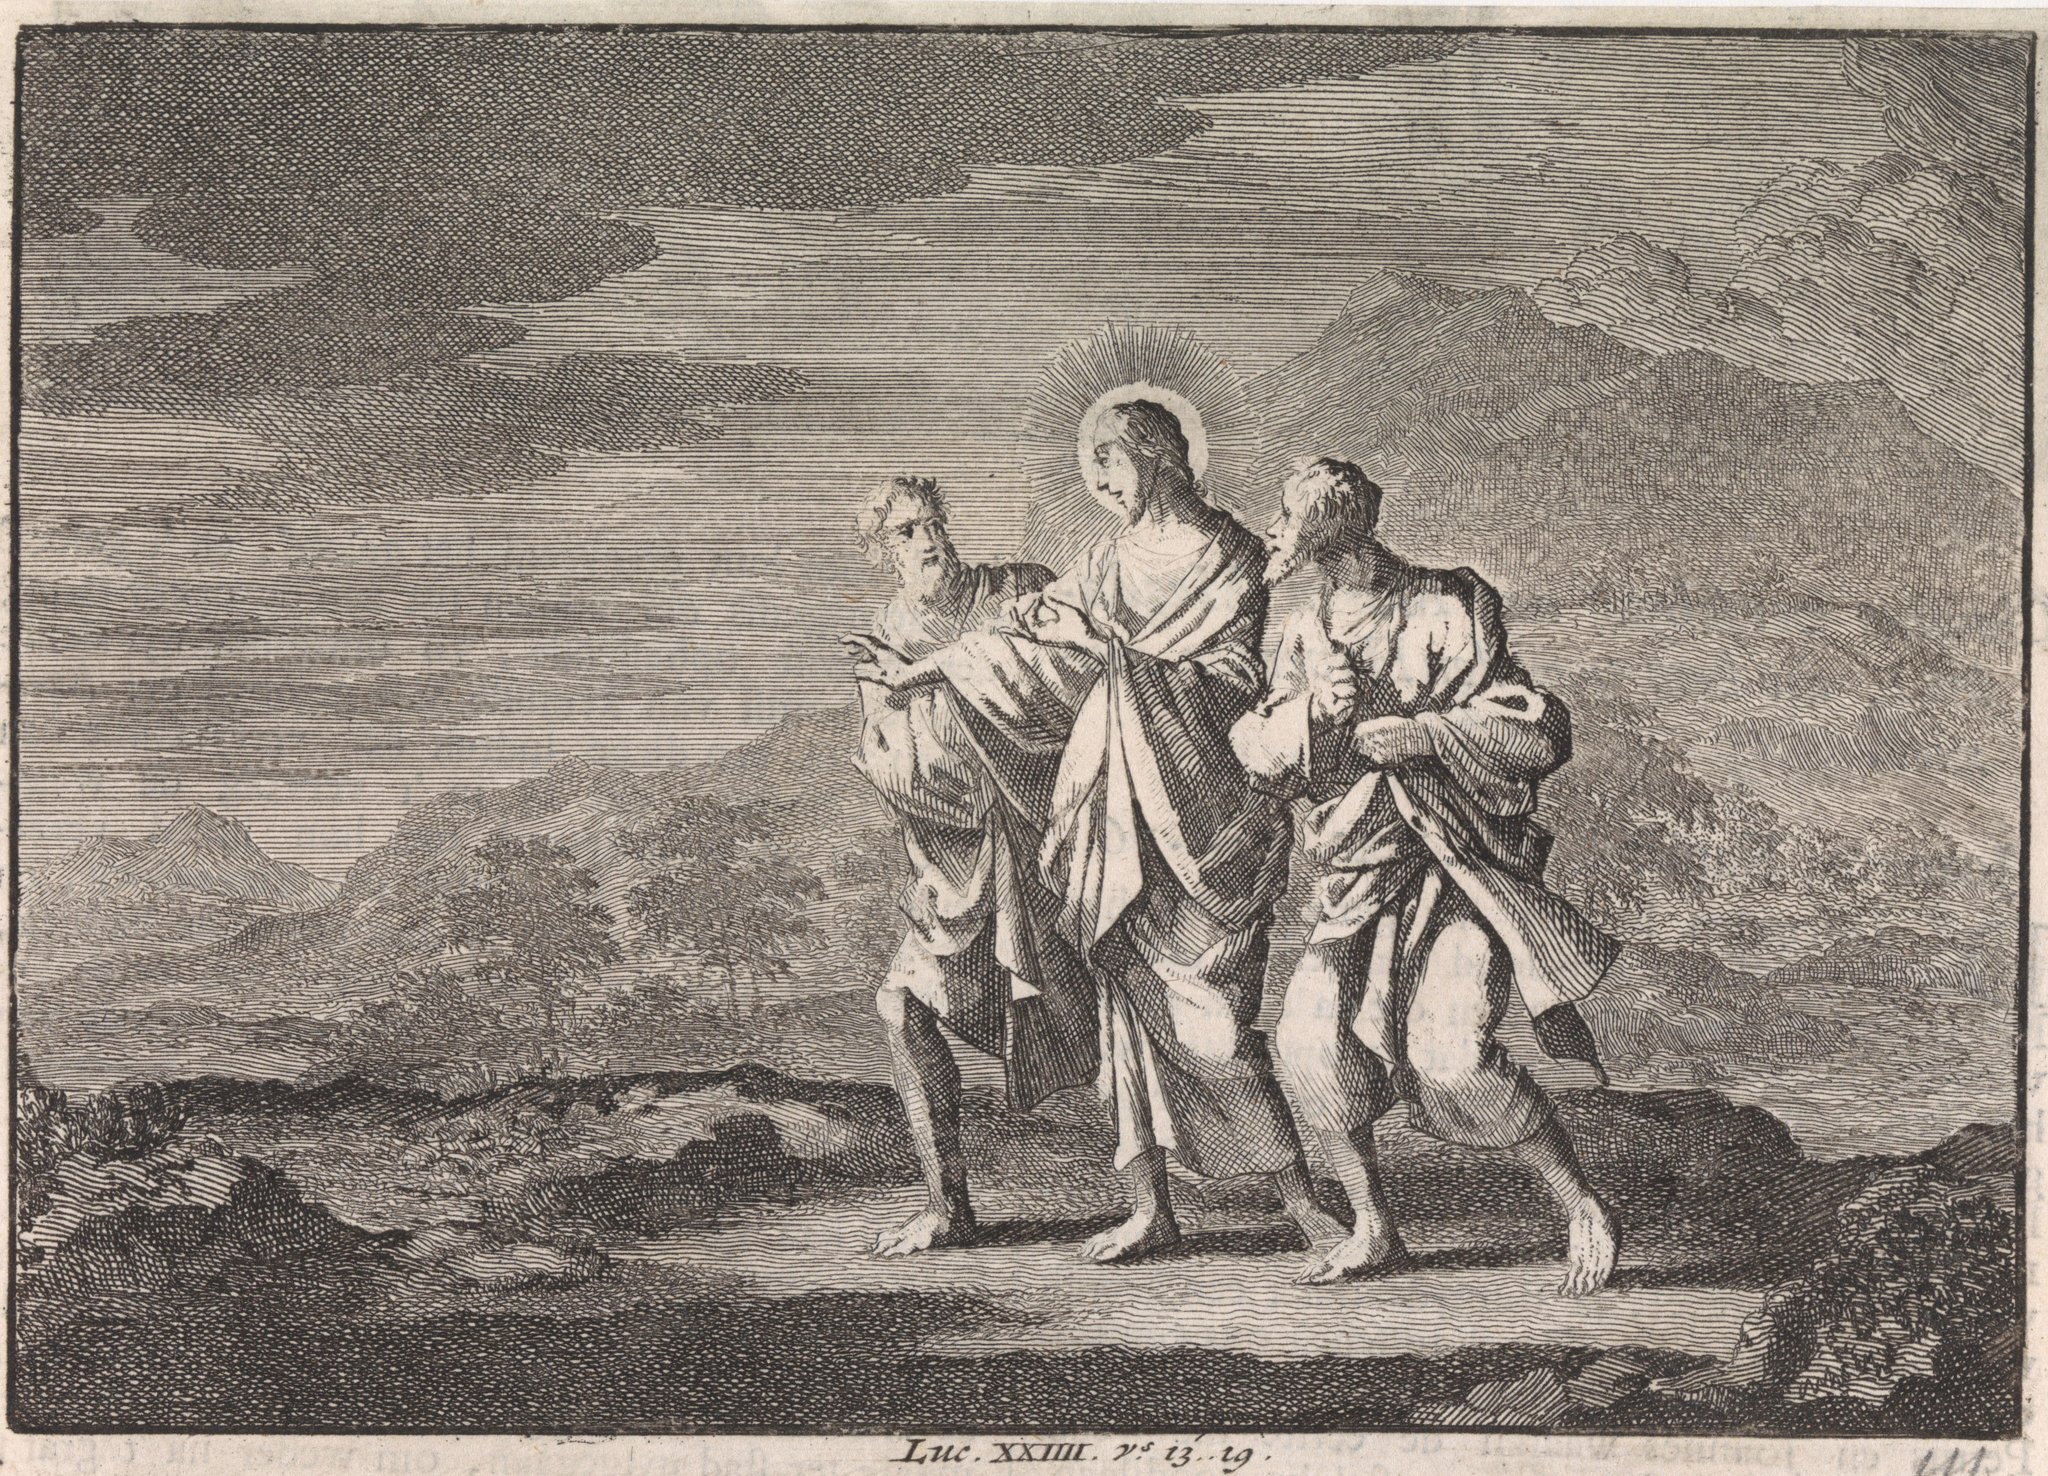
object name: book illustration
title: Emmaüsgangers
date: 1703-1762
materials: paper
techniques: etching, letterpress printing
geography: amsterdam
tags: the journey to emmaus: two disciples (cleopas and peter) under way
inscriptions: collector's mark: Lugt 2228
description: De prent komt een eerste keer voor als boekillustratie voor David Martin. Historie des Ouden en Nieuwen Testaments. Amsterdam, Pieter Mortier, 1703. Deel II. De boekillustraties voor de Mortierbijbel hebben verschillende staten en kopieën, waarbij de chronologische volgorde moeilijk te achterhalen valt. Als boekillustraties werden ze bovendien herhaaldelijk opnieuw gebruikt voor andere boekwerken.